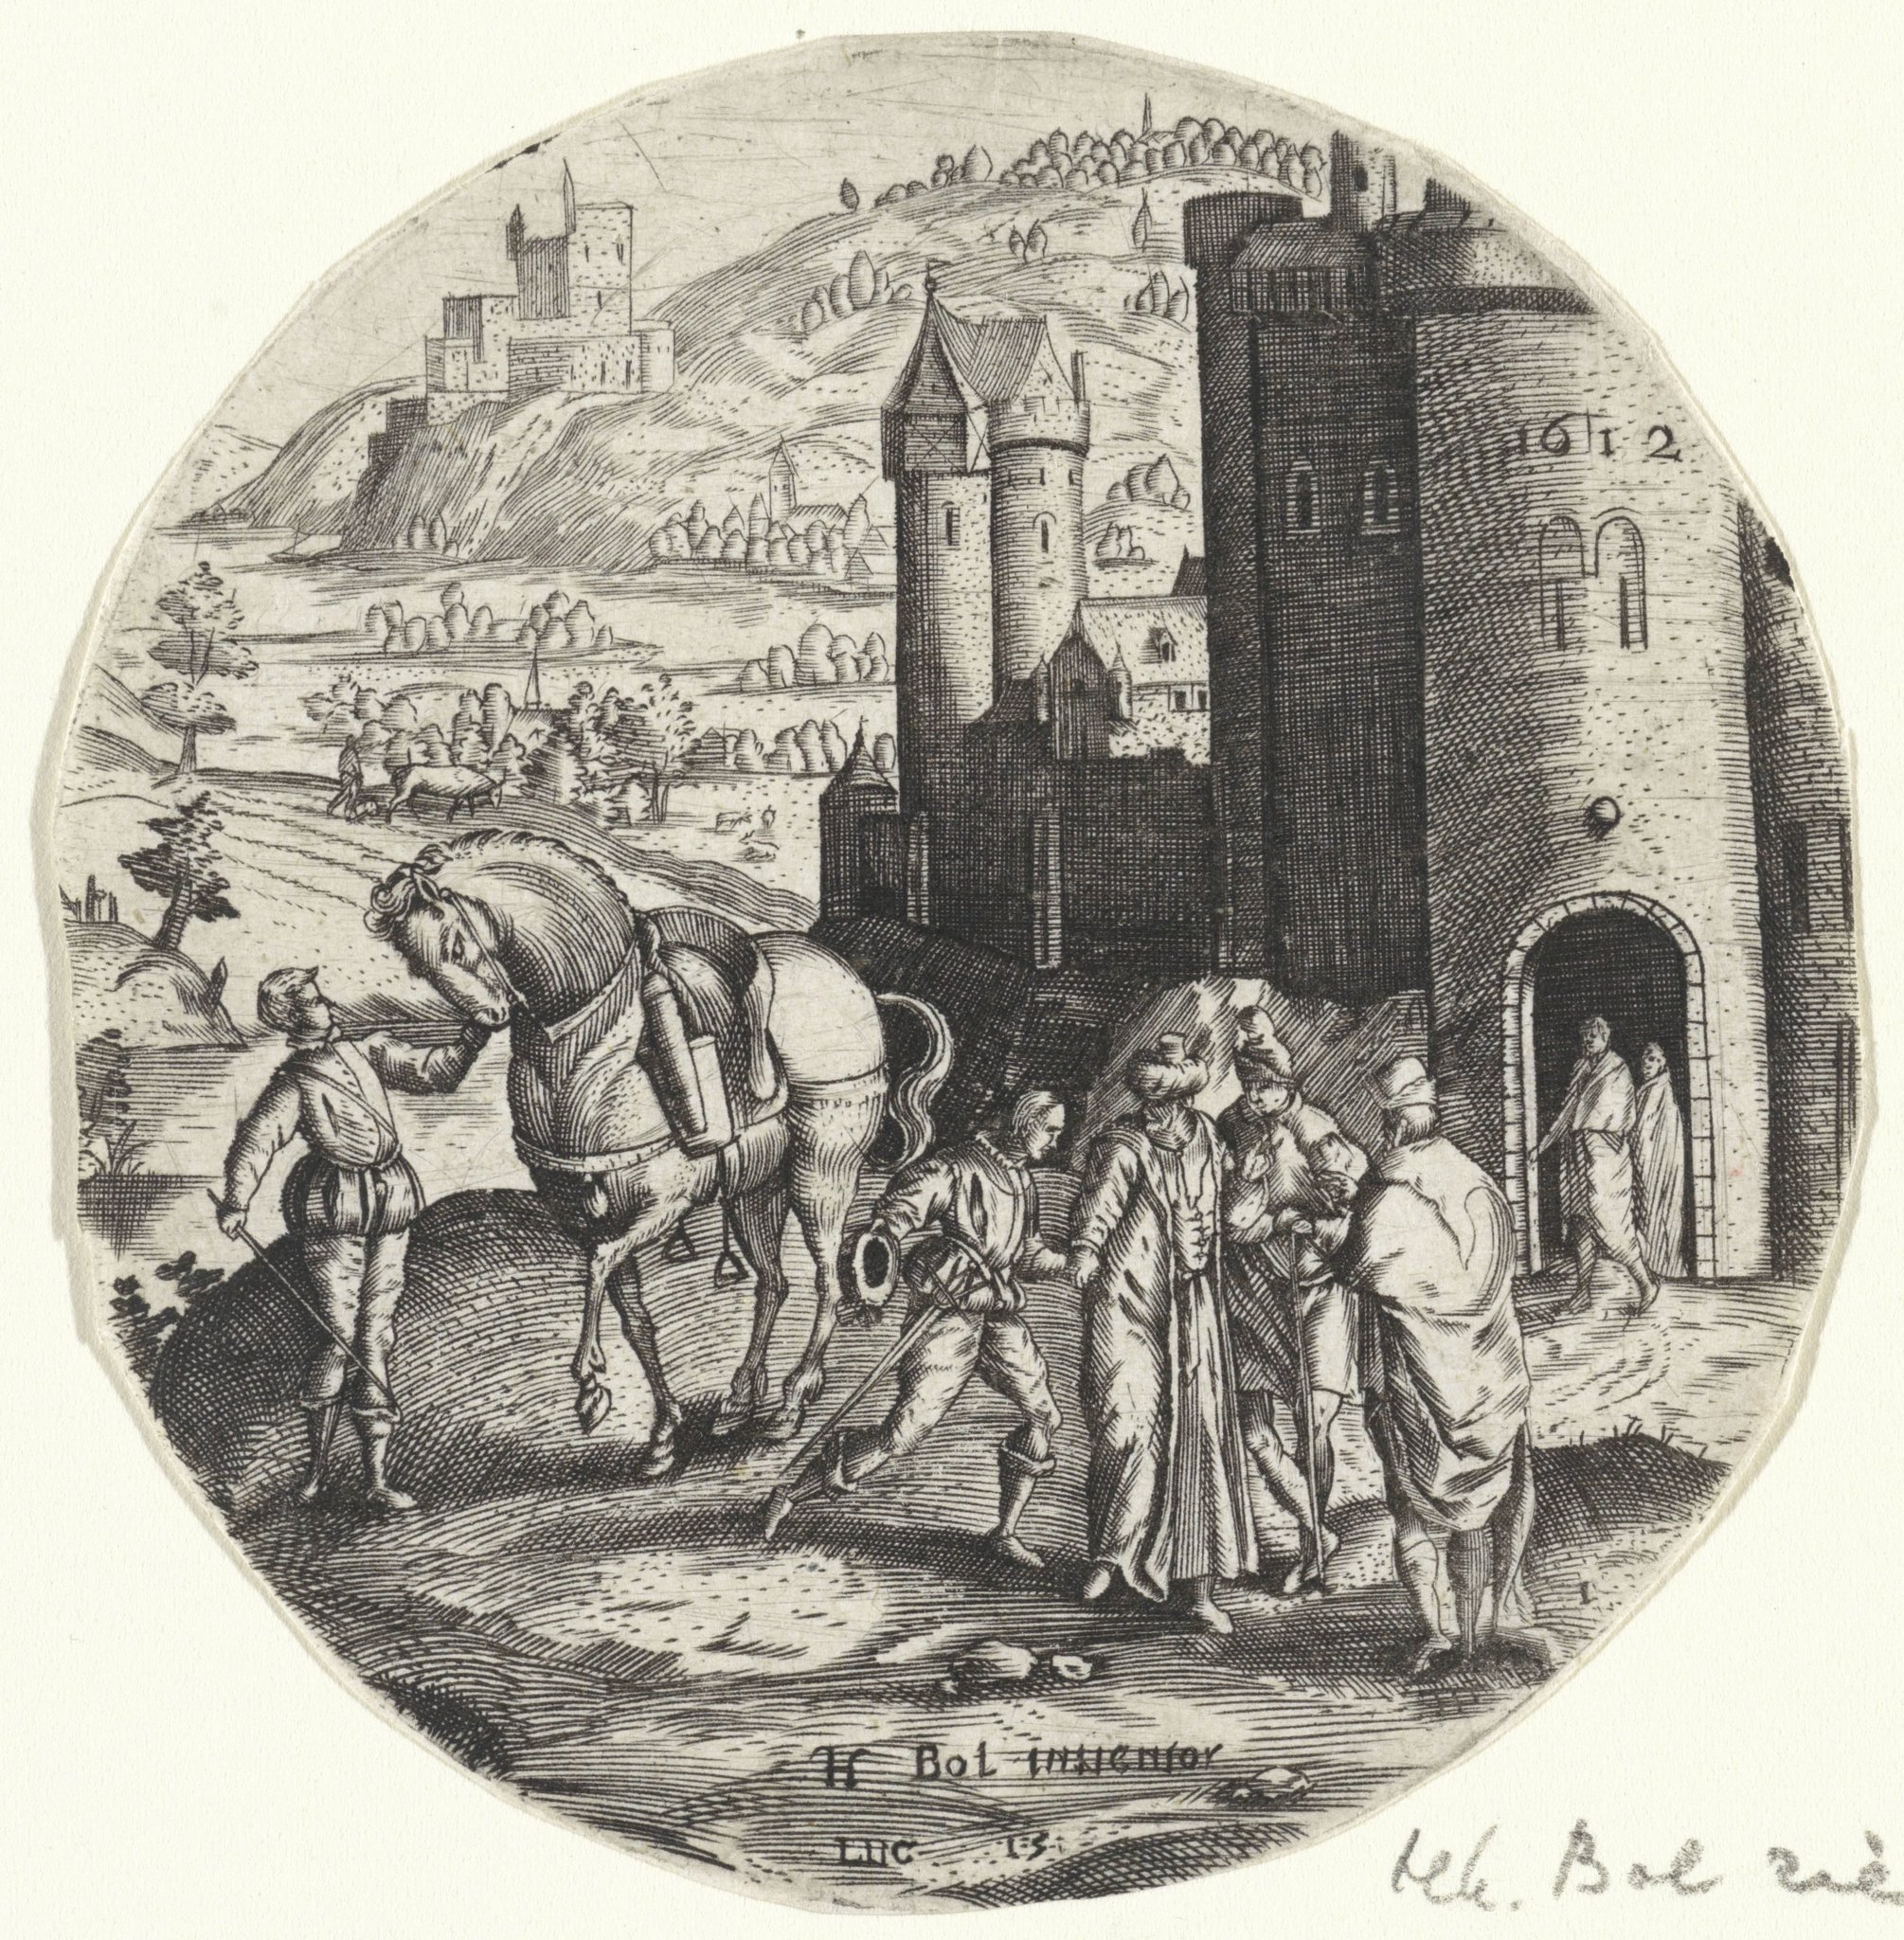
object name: print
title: Verloren zoon neemt afscheid van zijn vader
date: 1612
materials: paper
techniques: etching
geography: low countries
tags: leave-taking and departure of the prodigal son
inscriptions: date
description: De verloren zoon staat op het punt om zijn ouderlijk huis te verlaten en neemt afscheid van zijn vader, die met twee mannen in gesprek is. Achter hem houdt een jonge man zijn paard vast. Rechts staan nog twee figuren in de deuropening van een kasteel. Uit Luc. 15.